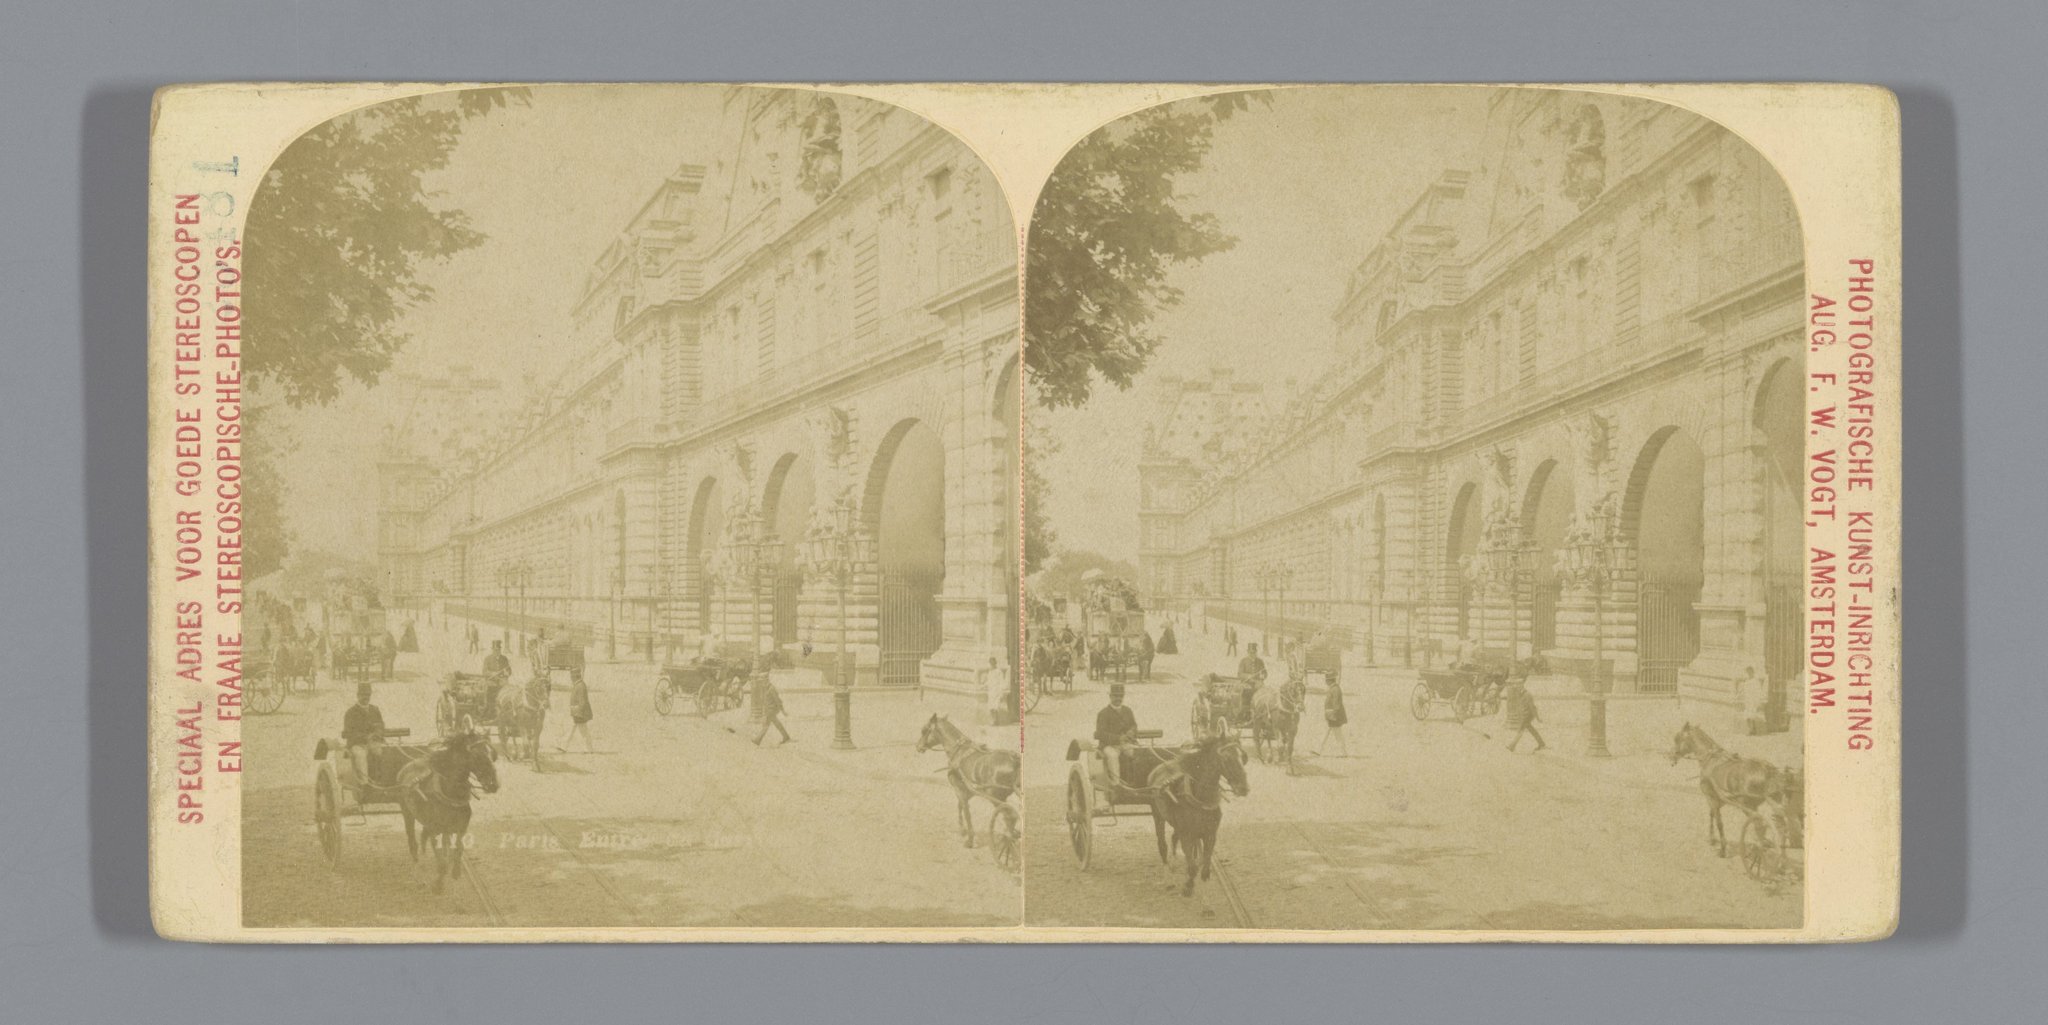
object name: stereograph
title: Gezicht op de Rue de Rivoli, met een deel van de gevel van het Musée du Louvre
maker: august frederik willem vogt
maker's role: fotograaf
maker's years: 1871-1922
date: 1875-1900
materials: cardboard, photographic support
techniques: albumen print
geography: rue de rivoli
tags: four-wheeled, animal-drawn vehicle, e.g.: cab, carriage, coach, façade (of house or building), street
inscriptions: number: ‘110’, inscription: ‘Speciaal adres voor goede stereoscopen en fraaie stereoscopische-photo's. photographische kunst-inrichting Aug. F. W. Vogt, Amsterdam.’, number: ‘25481’